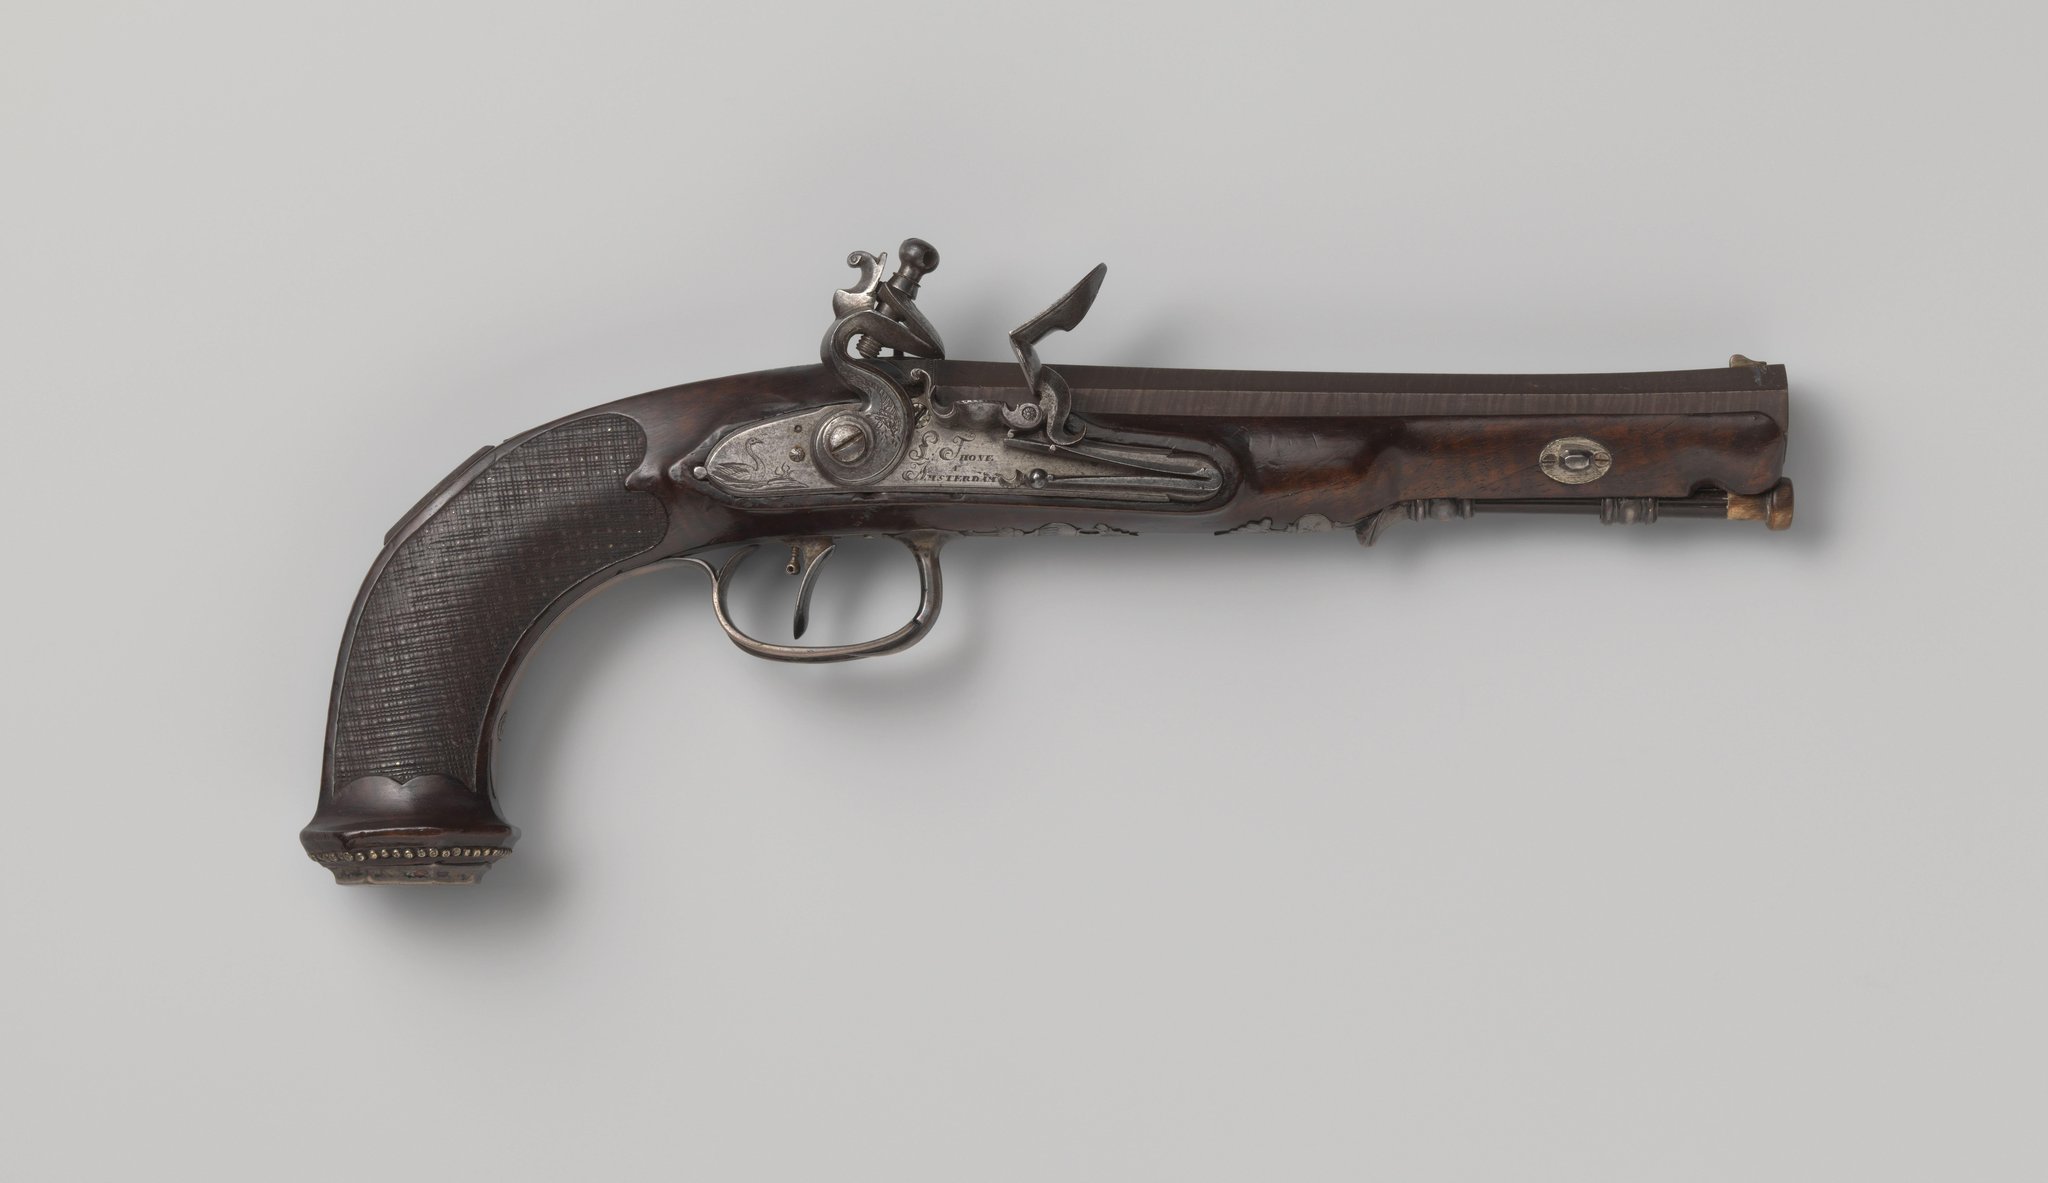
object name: flintlock pistol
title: Vuursteenpistool omgebouwd tot geweer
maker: lambertus michaelis thone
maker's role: weapon manufacturer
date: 1800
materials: baleen, horn, iron, silver, steel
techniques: burnishing, cutting, metalworking, engraving, inlay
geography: amsterdam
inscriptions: coat of arms, signature: ‘Thone amsterdam’, signature: ‘L.THONE // A // AMSTERDAM’